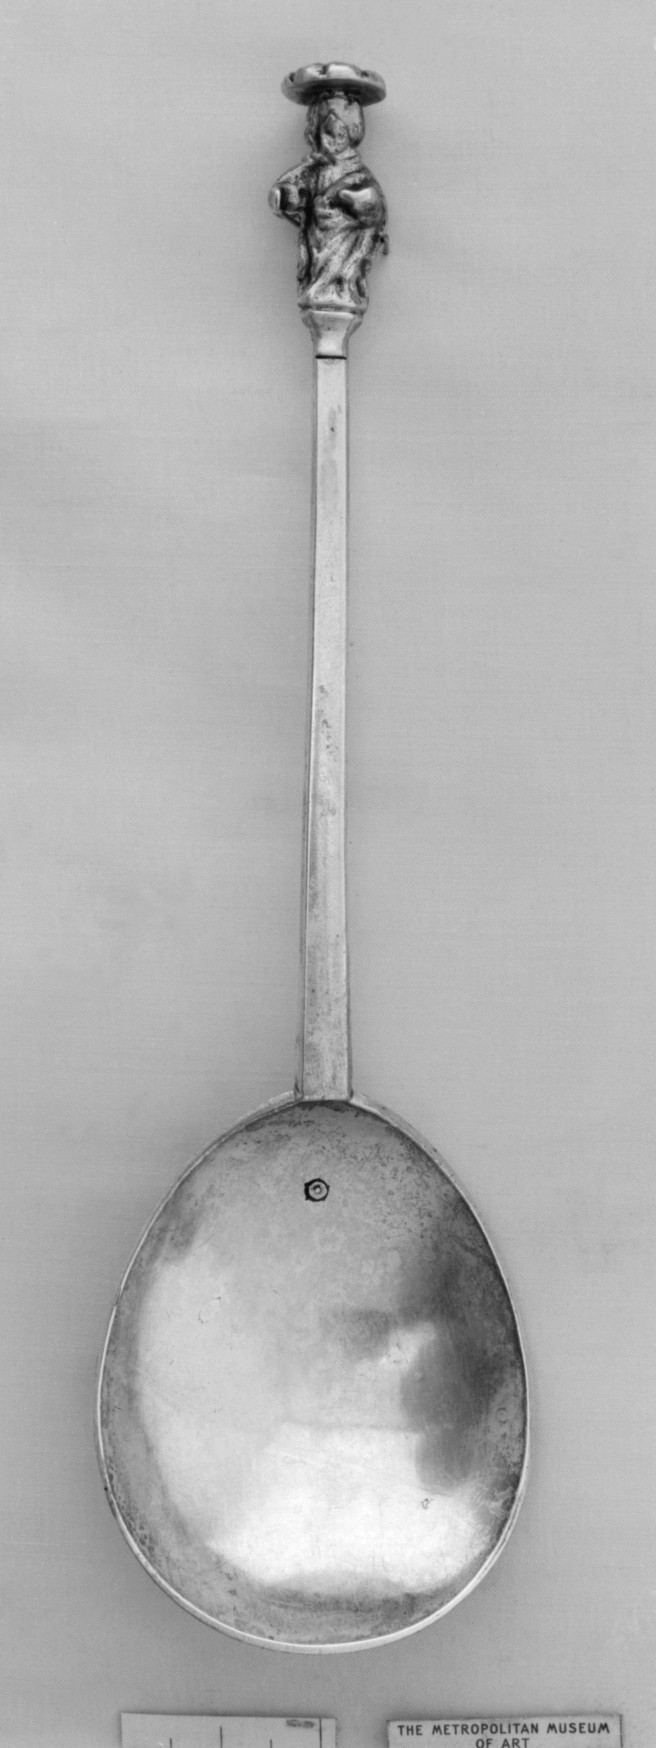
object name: apostle spoon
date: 1610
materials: gilt, silver